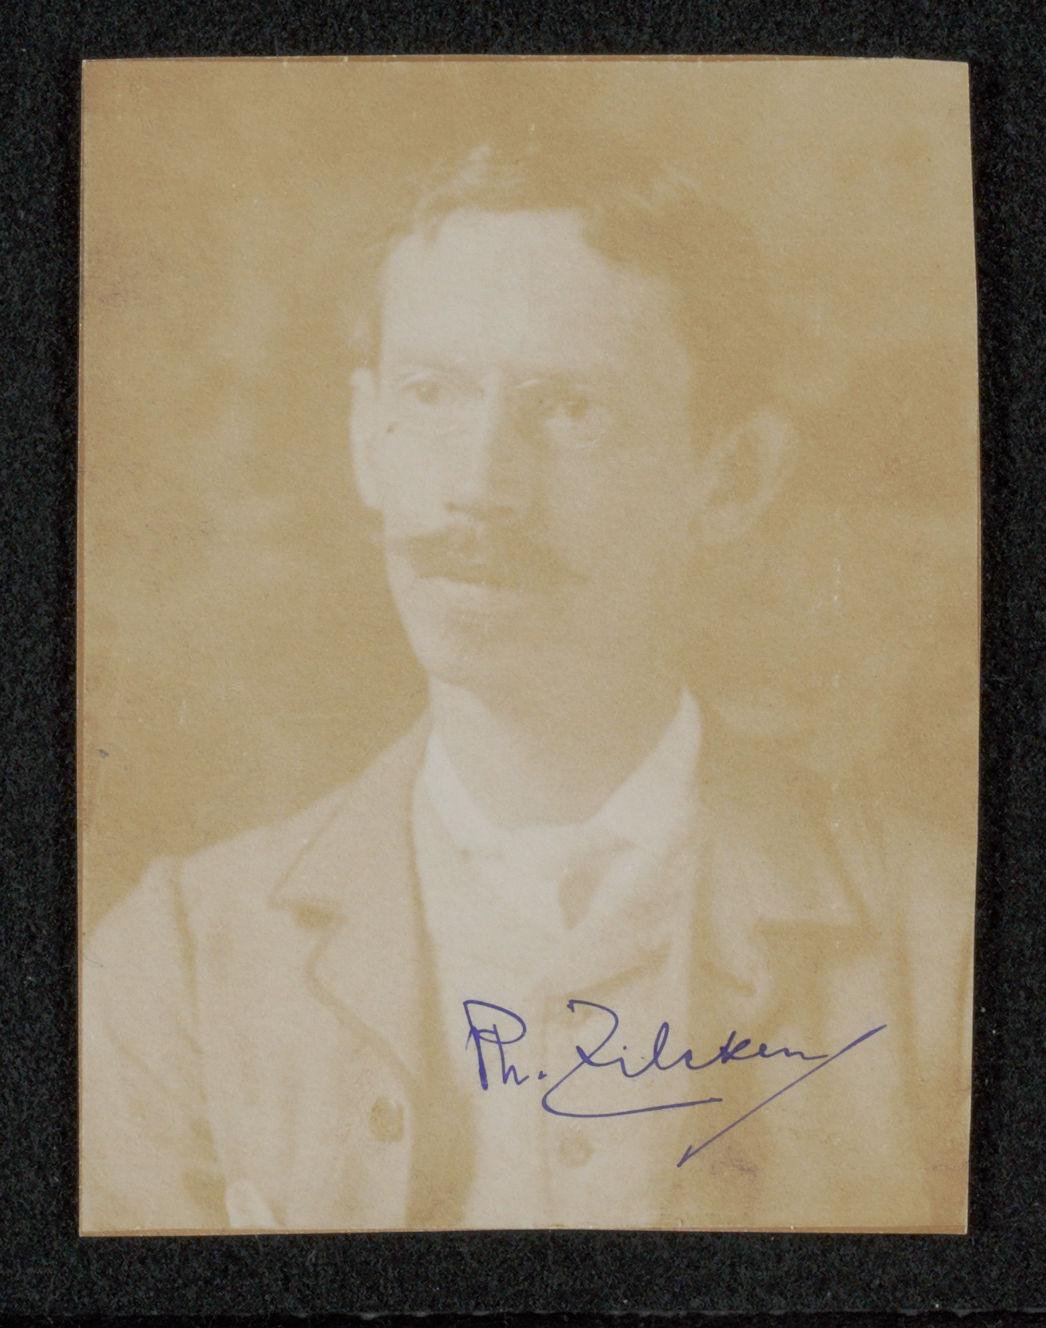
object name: photograph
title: Portret van Philip Zilcken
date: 1904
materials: ink, photographic support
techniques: collodion silver print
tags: the hague, painter, philip zilcken, historical persons (portraits and scenes from the life)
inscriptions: name: ‘Ph. Zilcken’